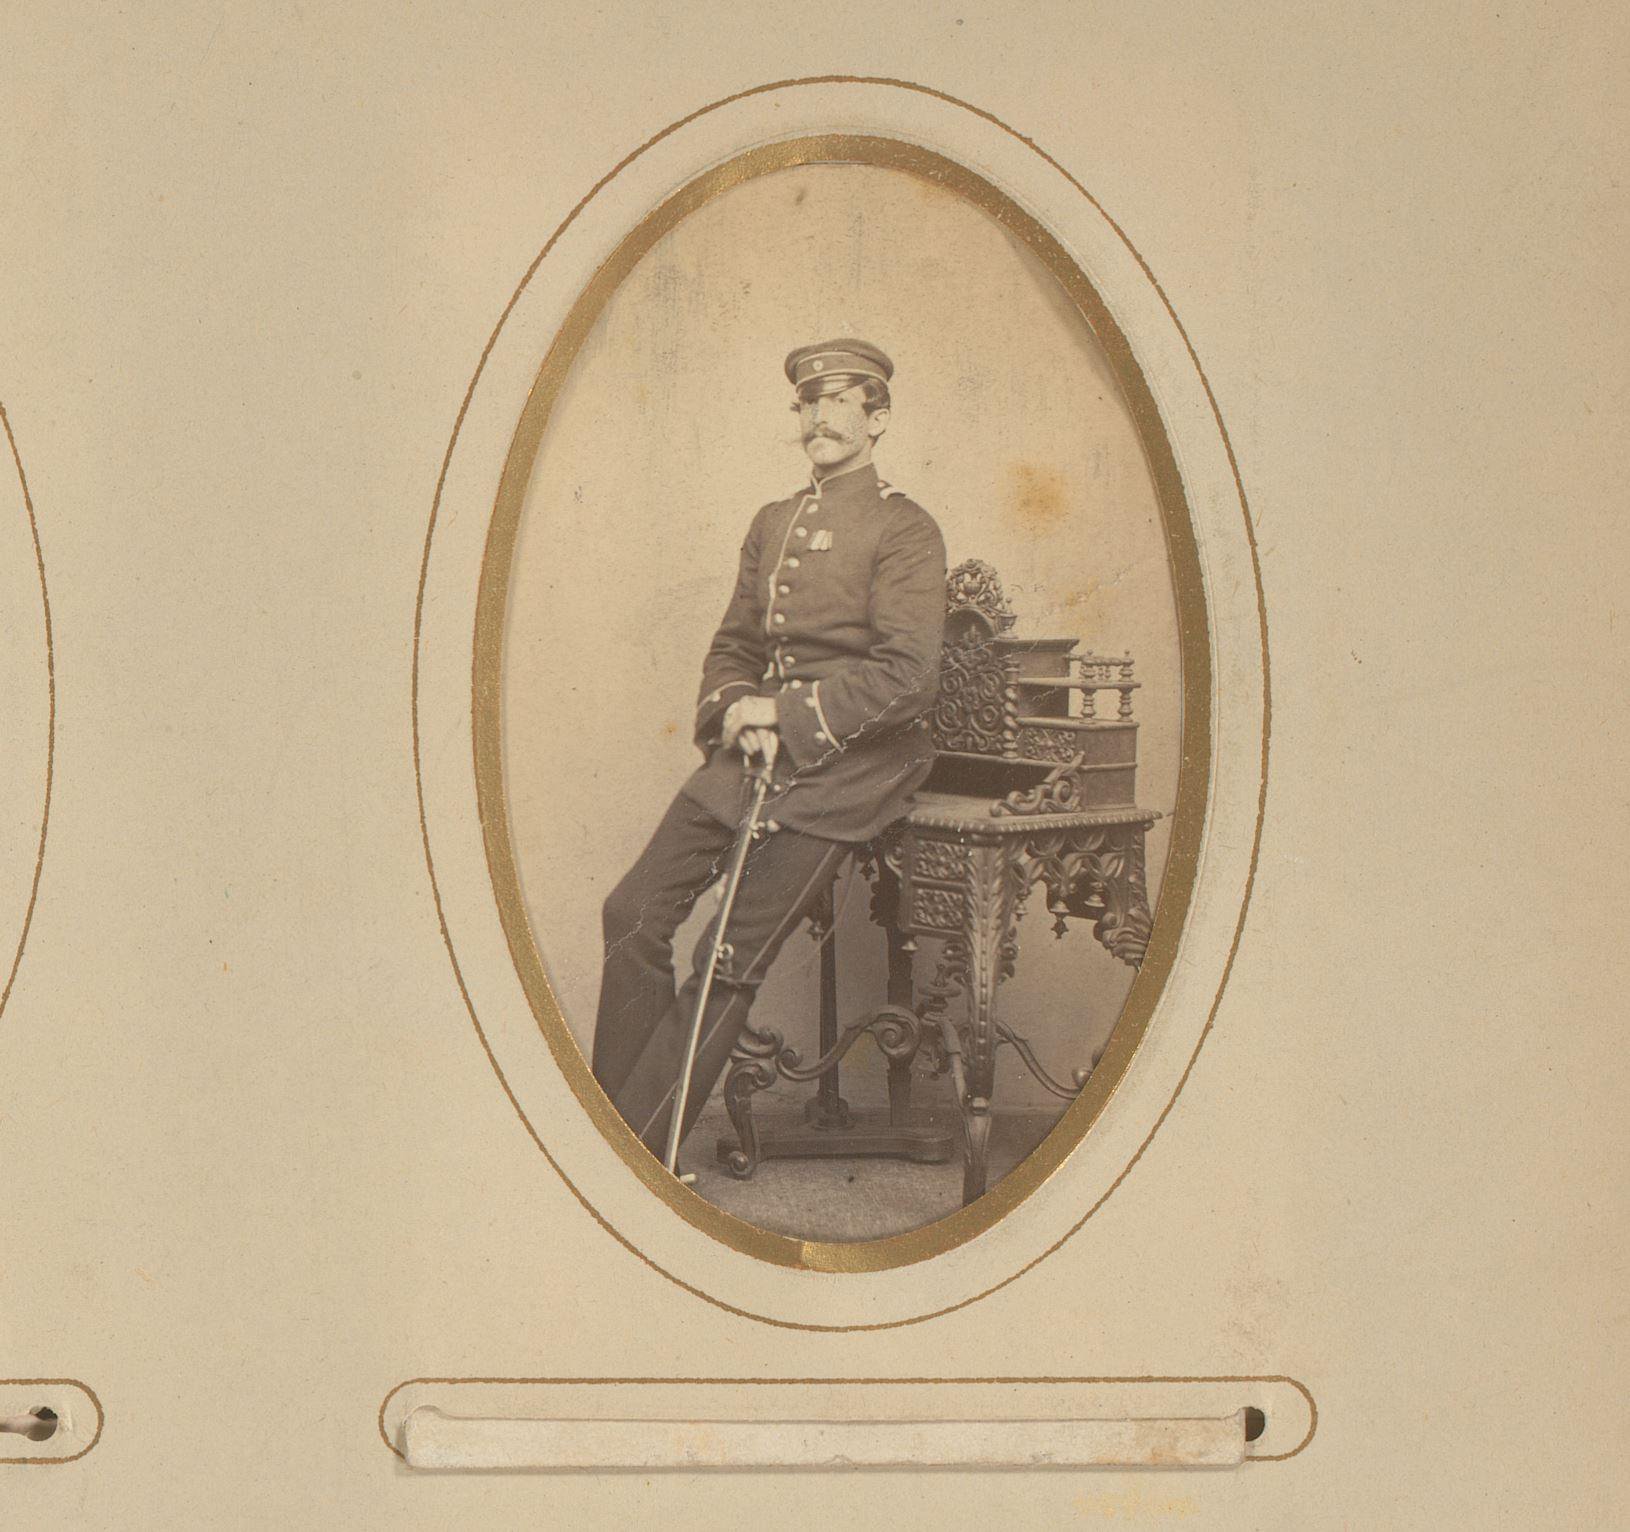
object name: carte de visite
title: Portret van een man in militair uniform, leunen op een schrijftafel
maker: albert schutze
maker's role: fotograaf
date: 1850-1900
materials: cardboard, photographic support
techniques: albumen print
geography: dresden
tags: writing-table, writing-desk, historical persons, (military) uniforms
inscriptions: inscription: ‘PHOTOGRAPHIE/ von/ Albert Schütze/ in/ DRESDEN/ (Neustadt)/ Hauptstrasse, No 9.’